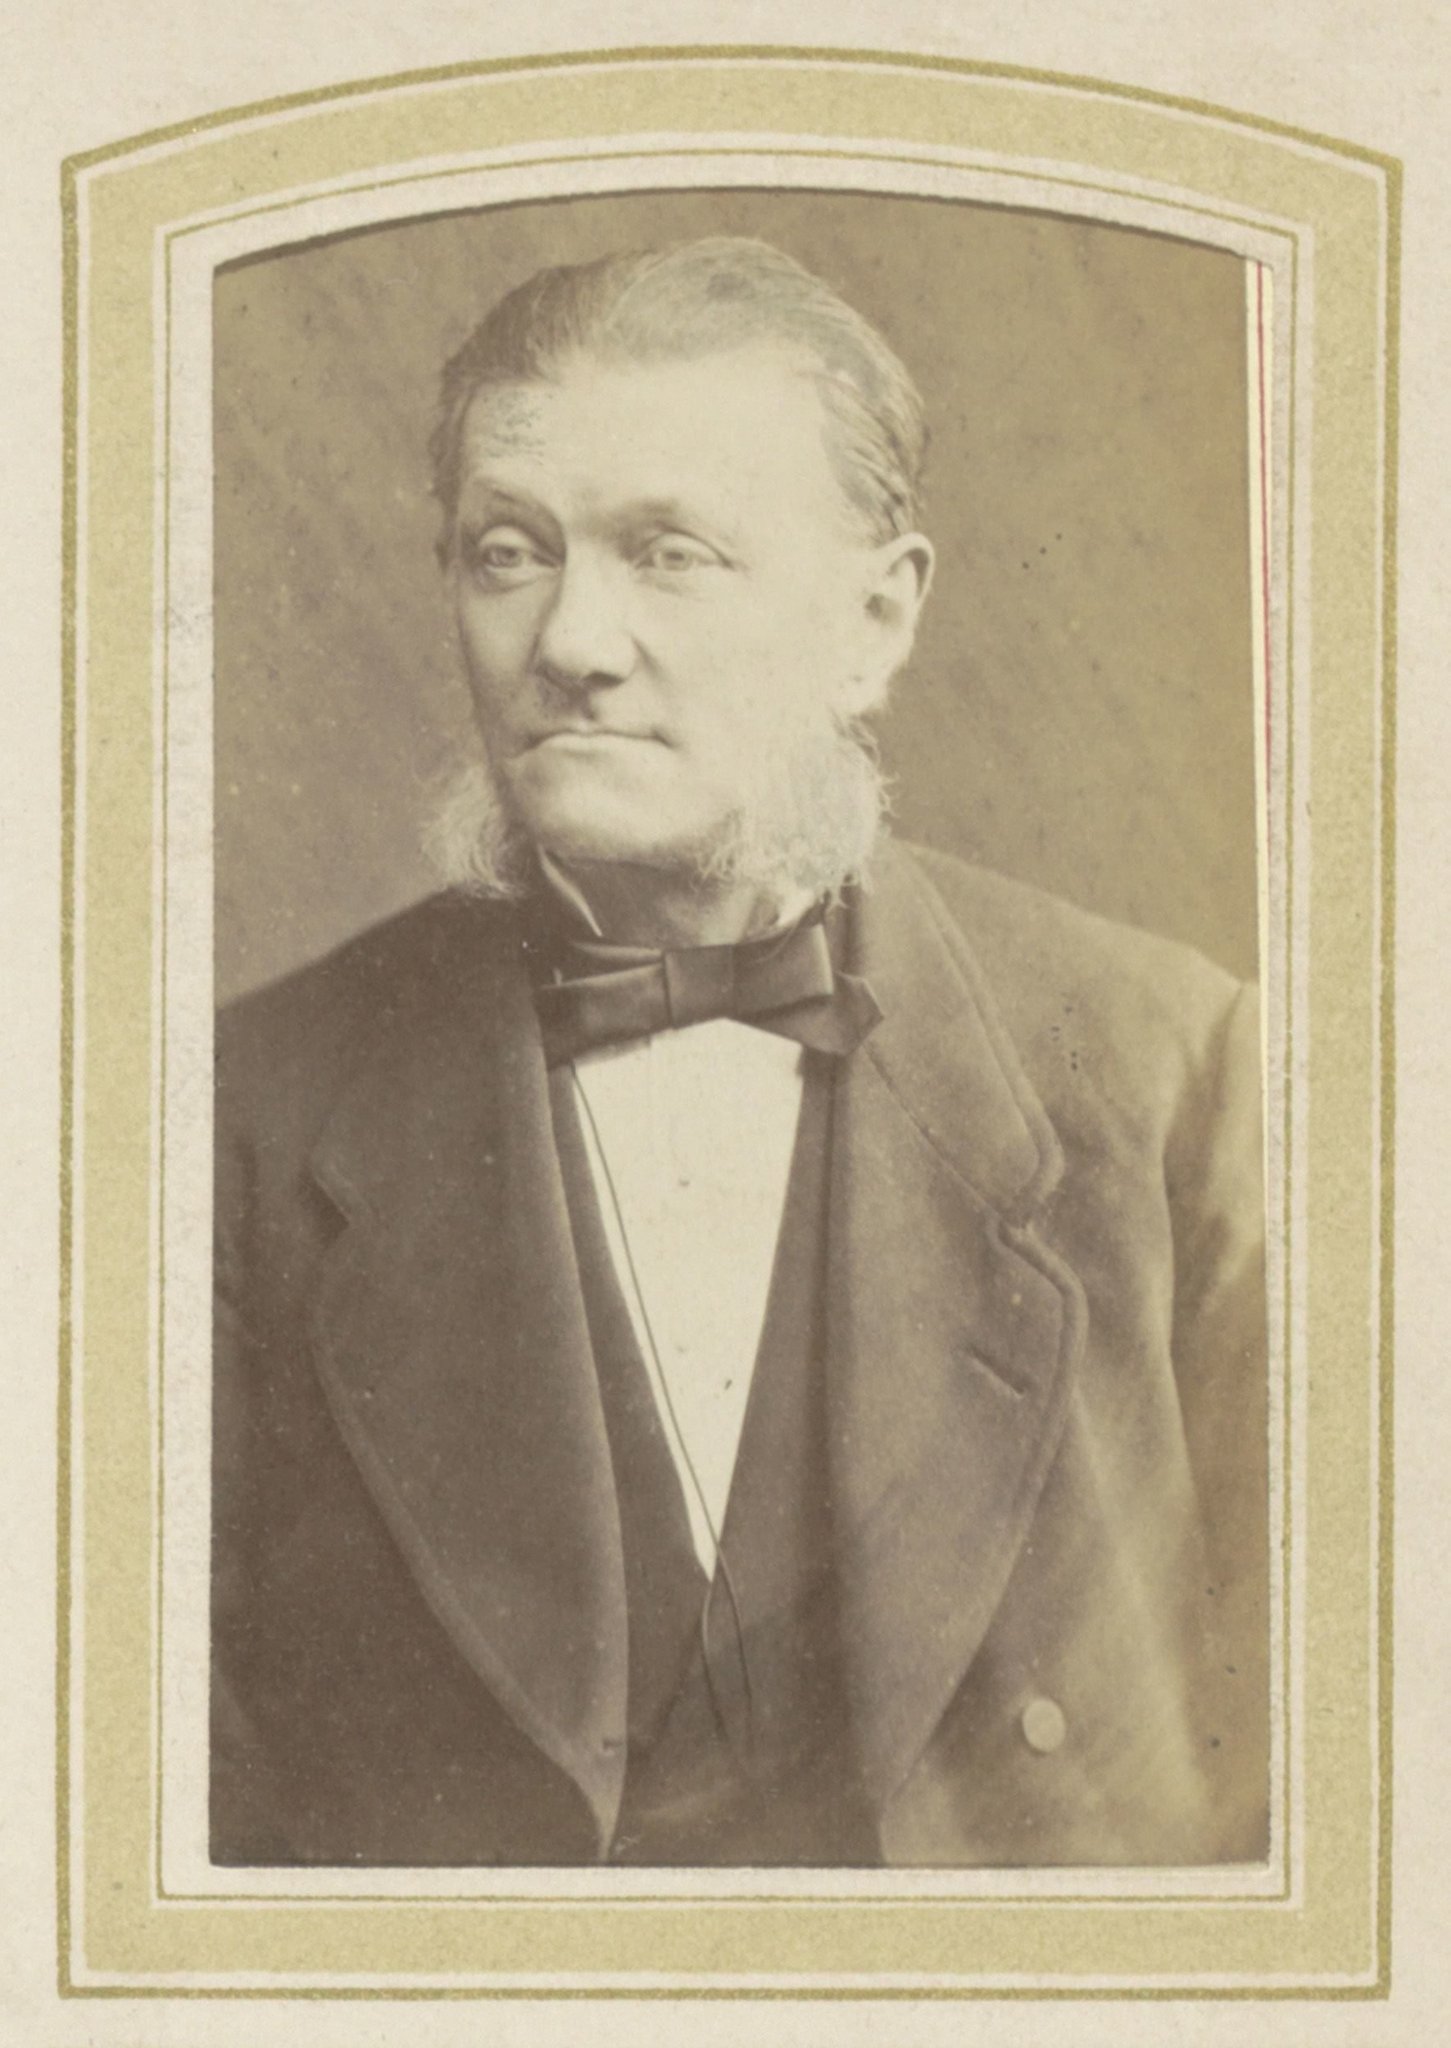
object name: carte de visite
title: Portret van een man met bakkebaarden, een strikje en een jas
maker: friedrich julius von kolkow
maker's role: fotograaf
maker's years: 1839-1914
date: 1877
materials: cardboard, paper, photographic support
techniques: albumen print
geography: groningen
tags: sideburns, historical persons, neck-gear ~ clothing, clothing for the upper part of the body, hairdress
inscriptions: address: ‘Groningen’, inscription: ‘1877’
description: Onderdeel van Fotoalbum van een Nederlandse familie met 168 cartes-de-visite en kabinetfoto's.